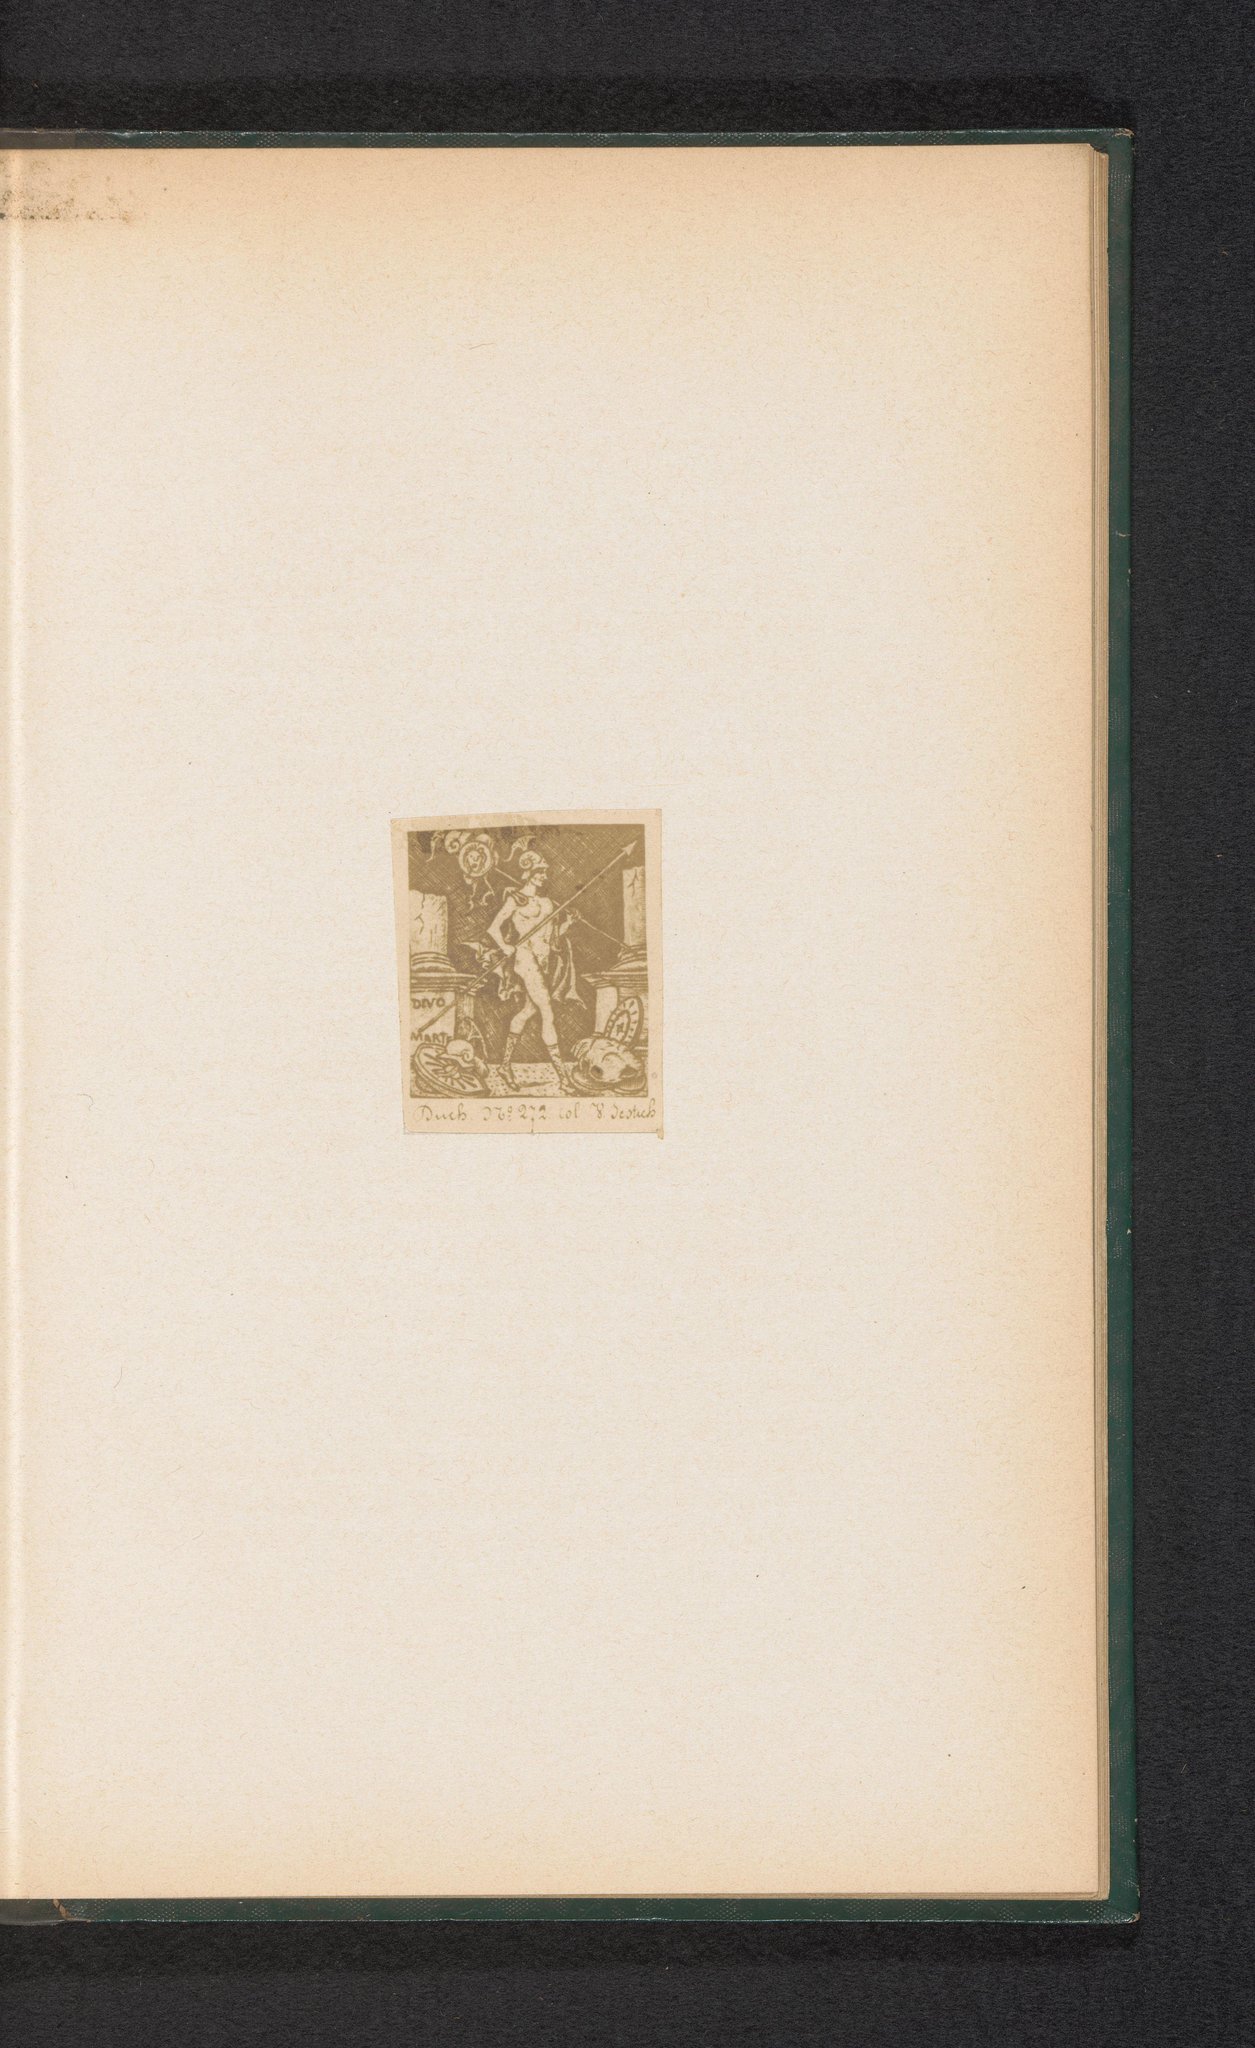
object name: page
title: Fotoreproductie van een prent van een krijger met een trofee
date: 1852-1857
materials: photographic support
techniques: salted paper print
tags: adult man, trophy ~ battle, war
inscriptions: inscription: ‘Duch. No 272. col. V. Sestich’